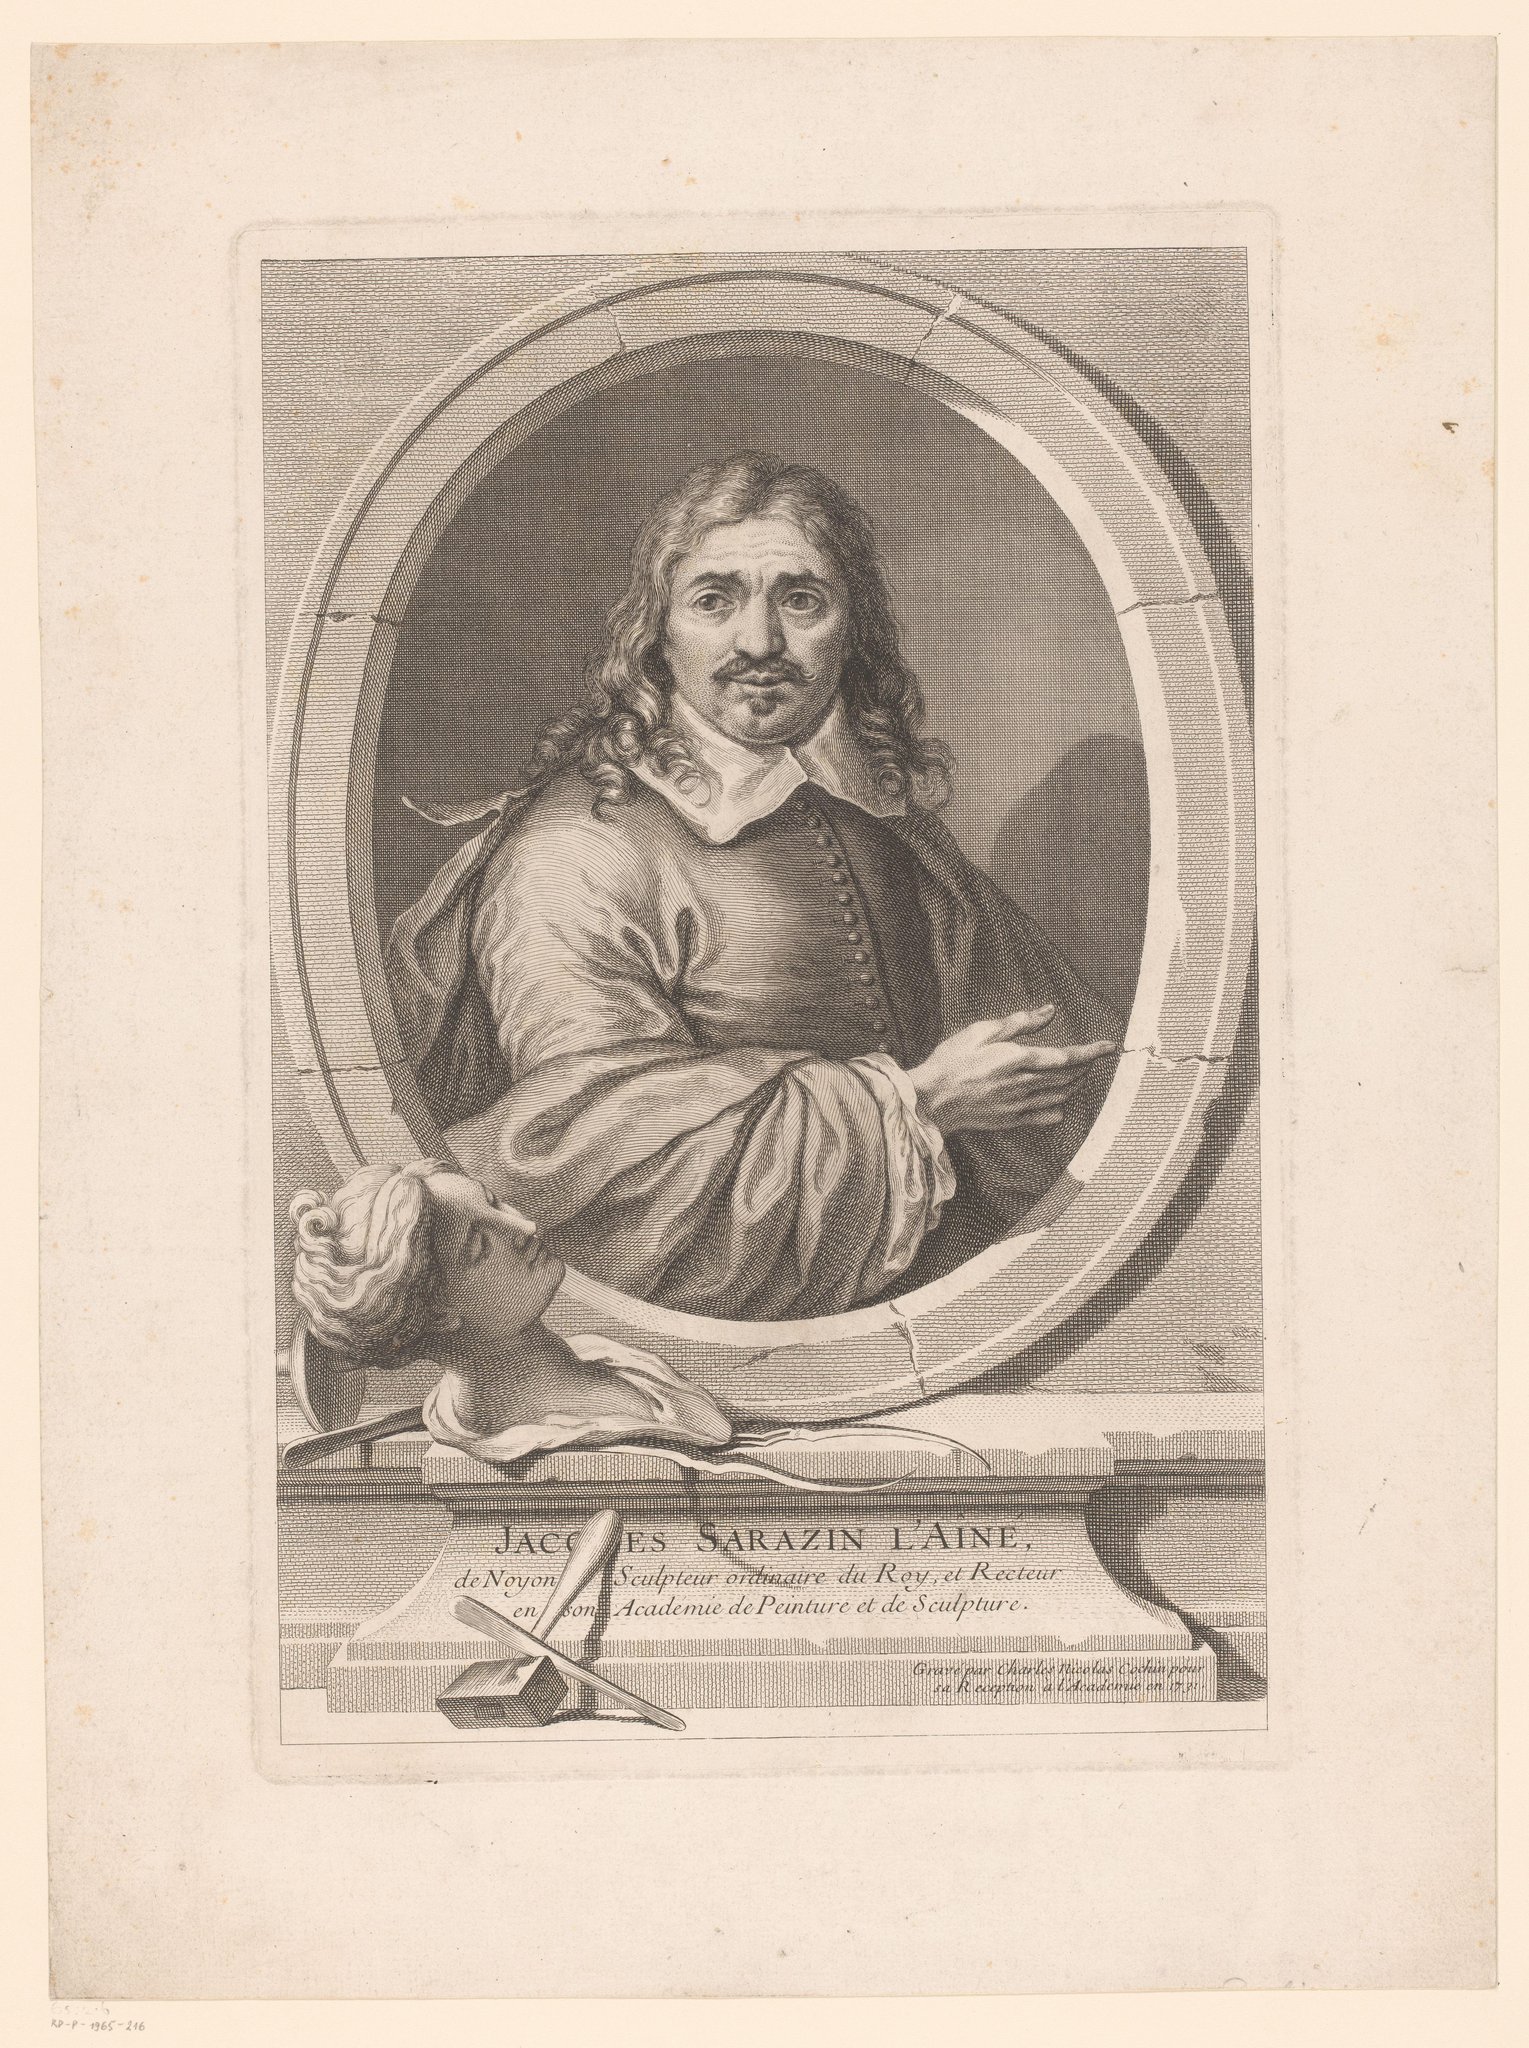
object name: print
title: Jacques Sarazin l'Aîné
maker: charles nicolas cochin (i)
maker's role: print maker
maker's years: 1688-1754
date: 1731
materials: paper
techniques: engraving, etching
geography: france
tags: paris, jacques sarazin, portrait, self-portrait of sculptor, ornament ~ medallion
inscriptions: collector's mark: Lugt 2760, collector's mark: Lugt 2228